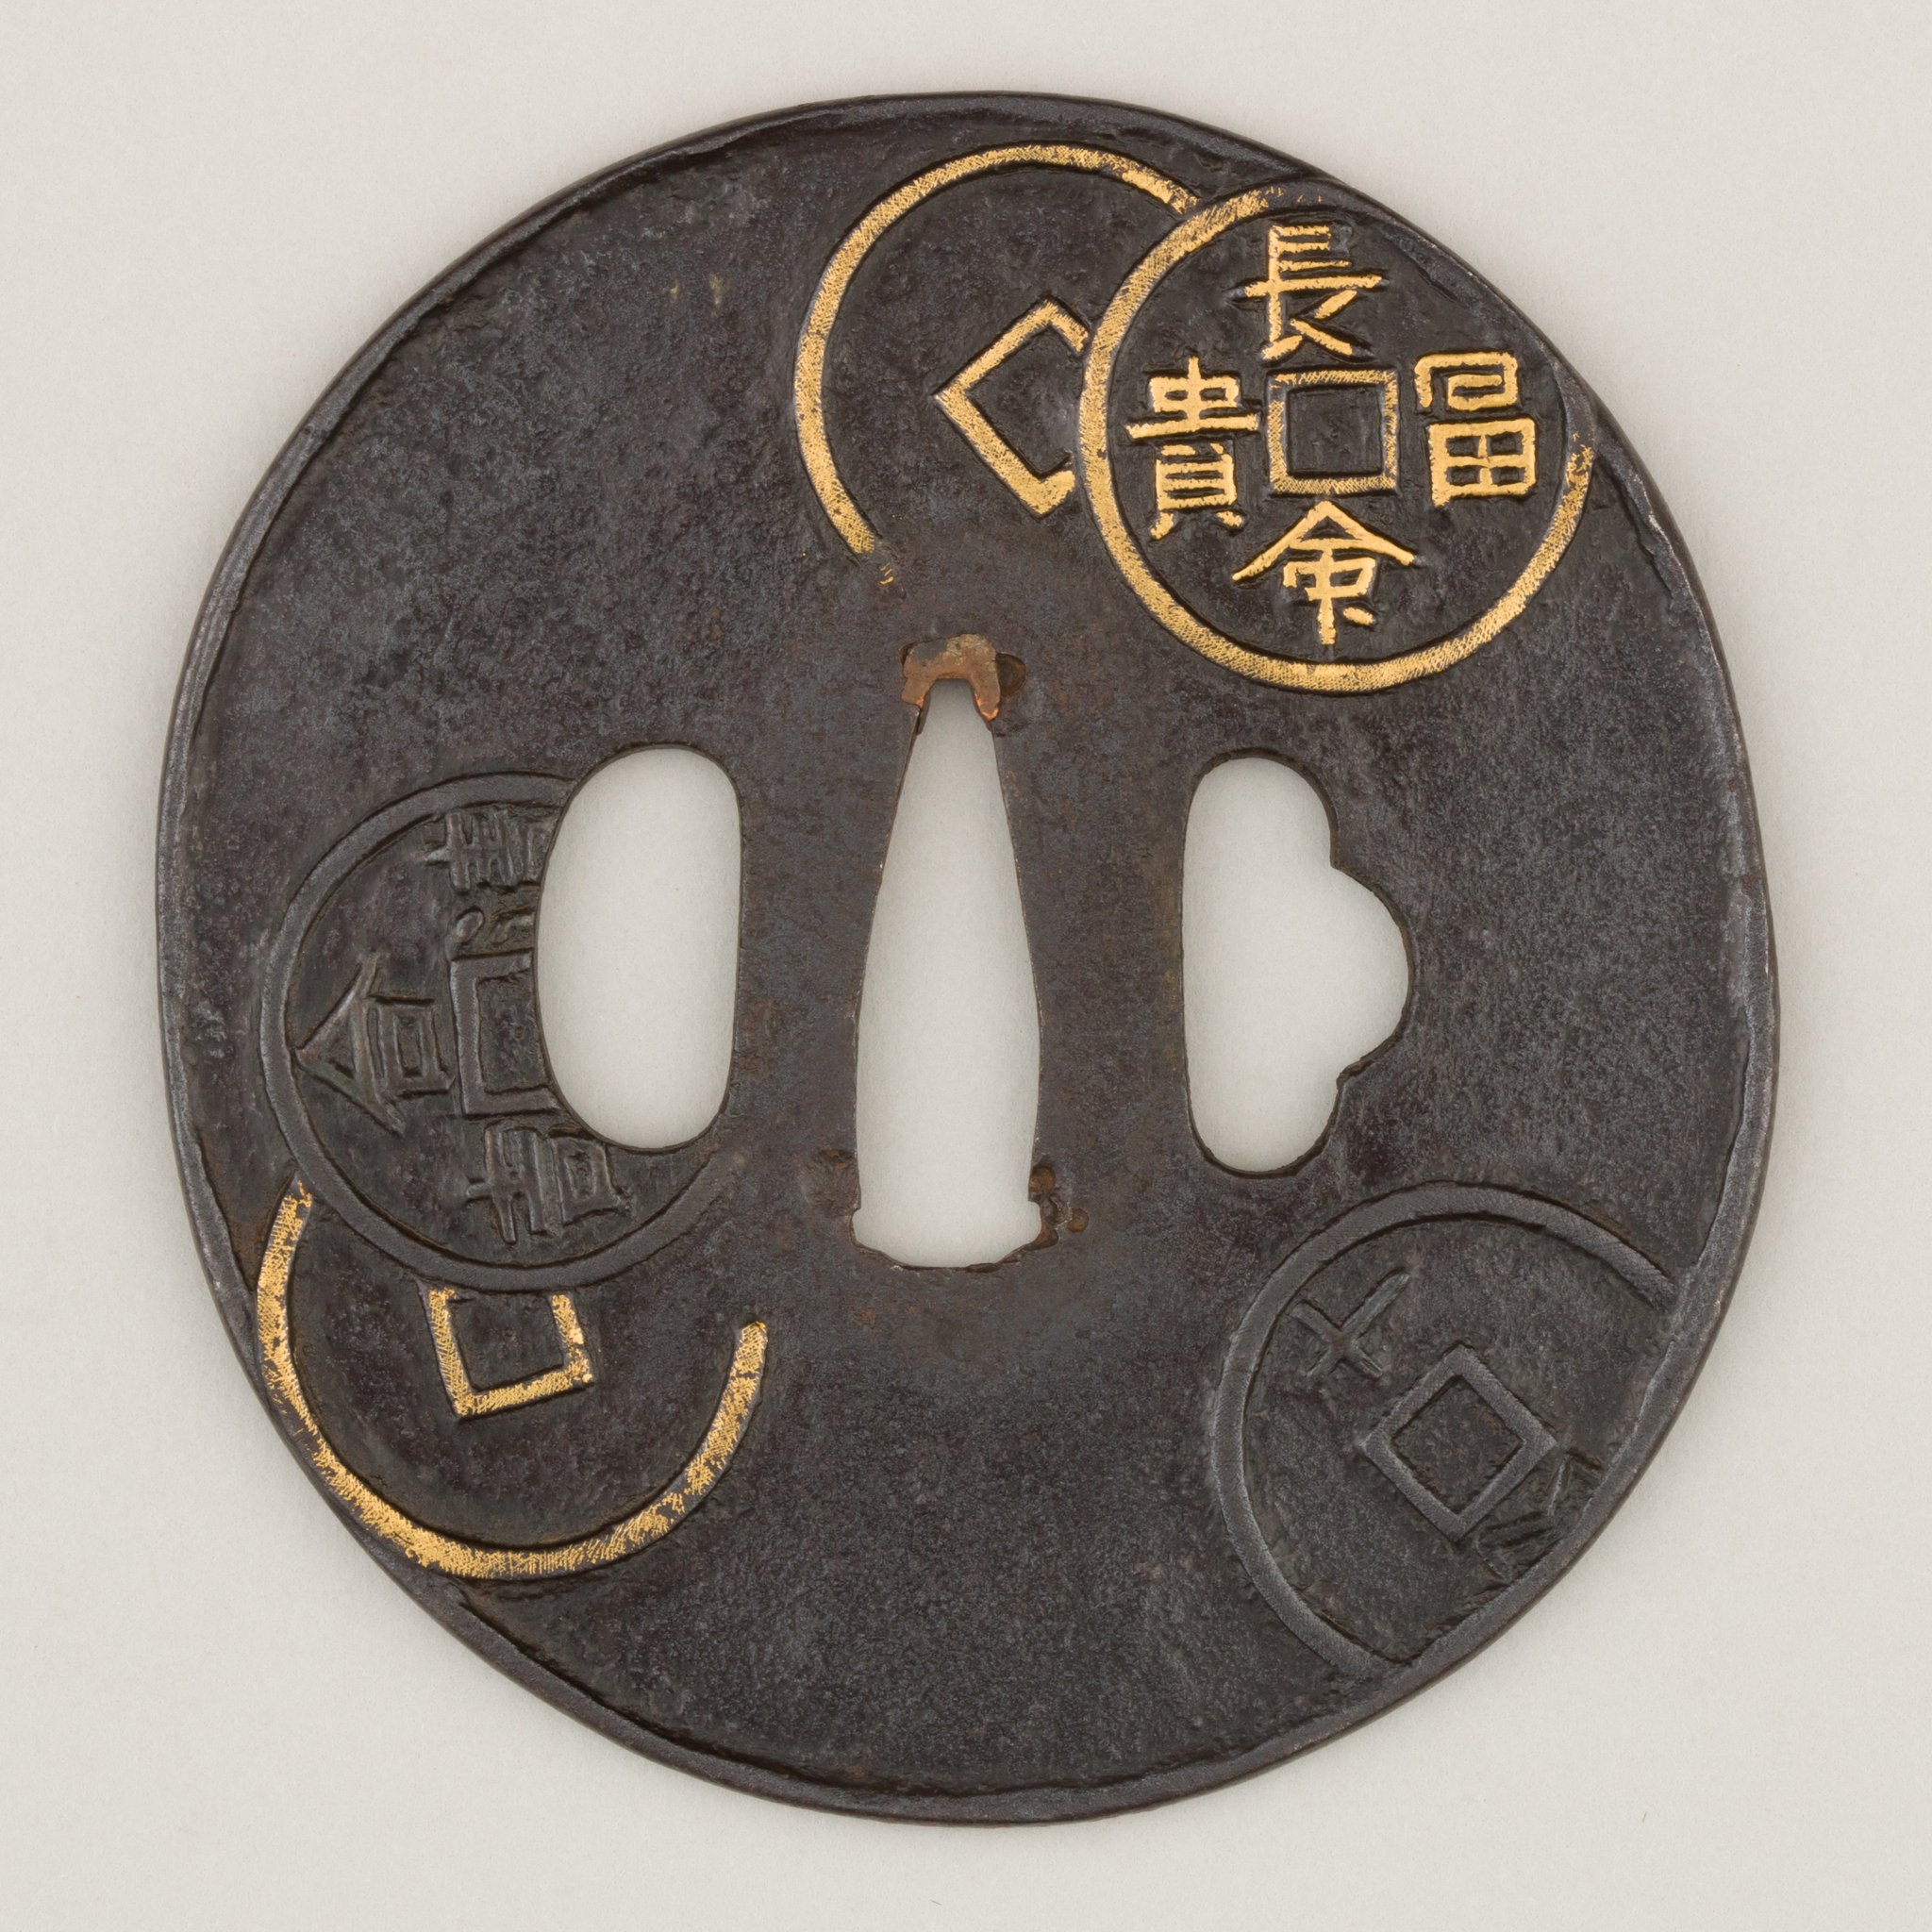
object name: sword guard tsuba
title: Sword Guard (Tsuba)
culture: japanese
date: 1601-1700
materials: copper, gold, iron, silver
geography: japan